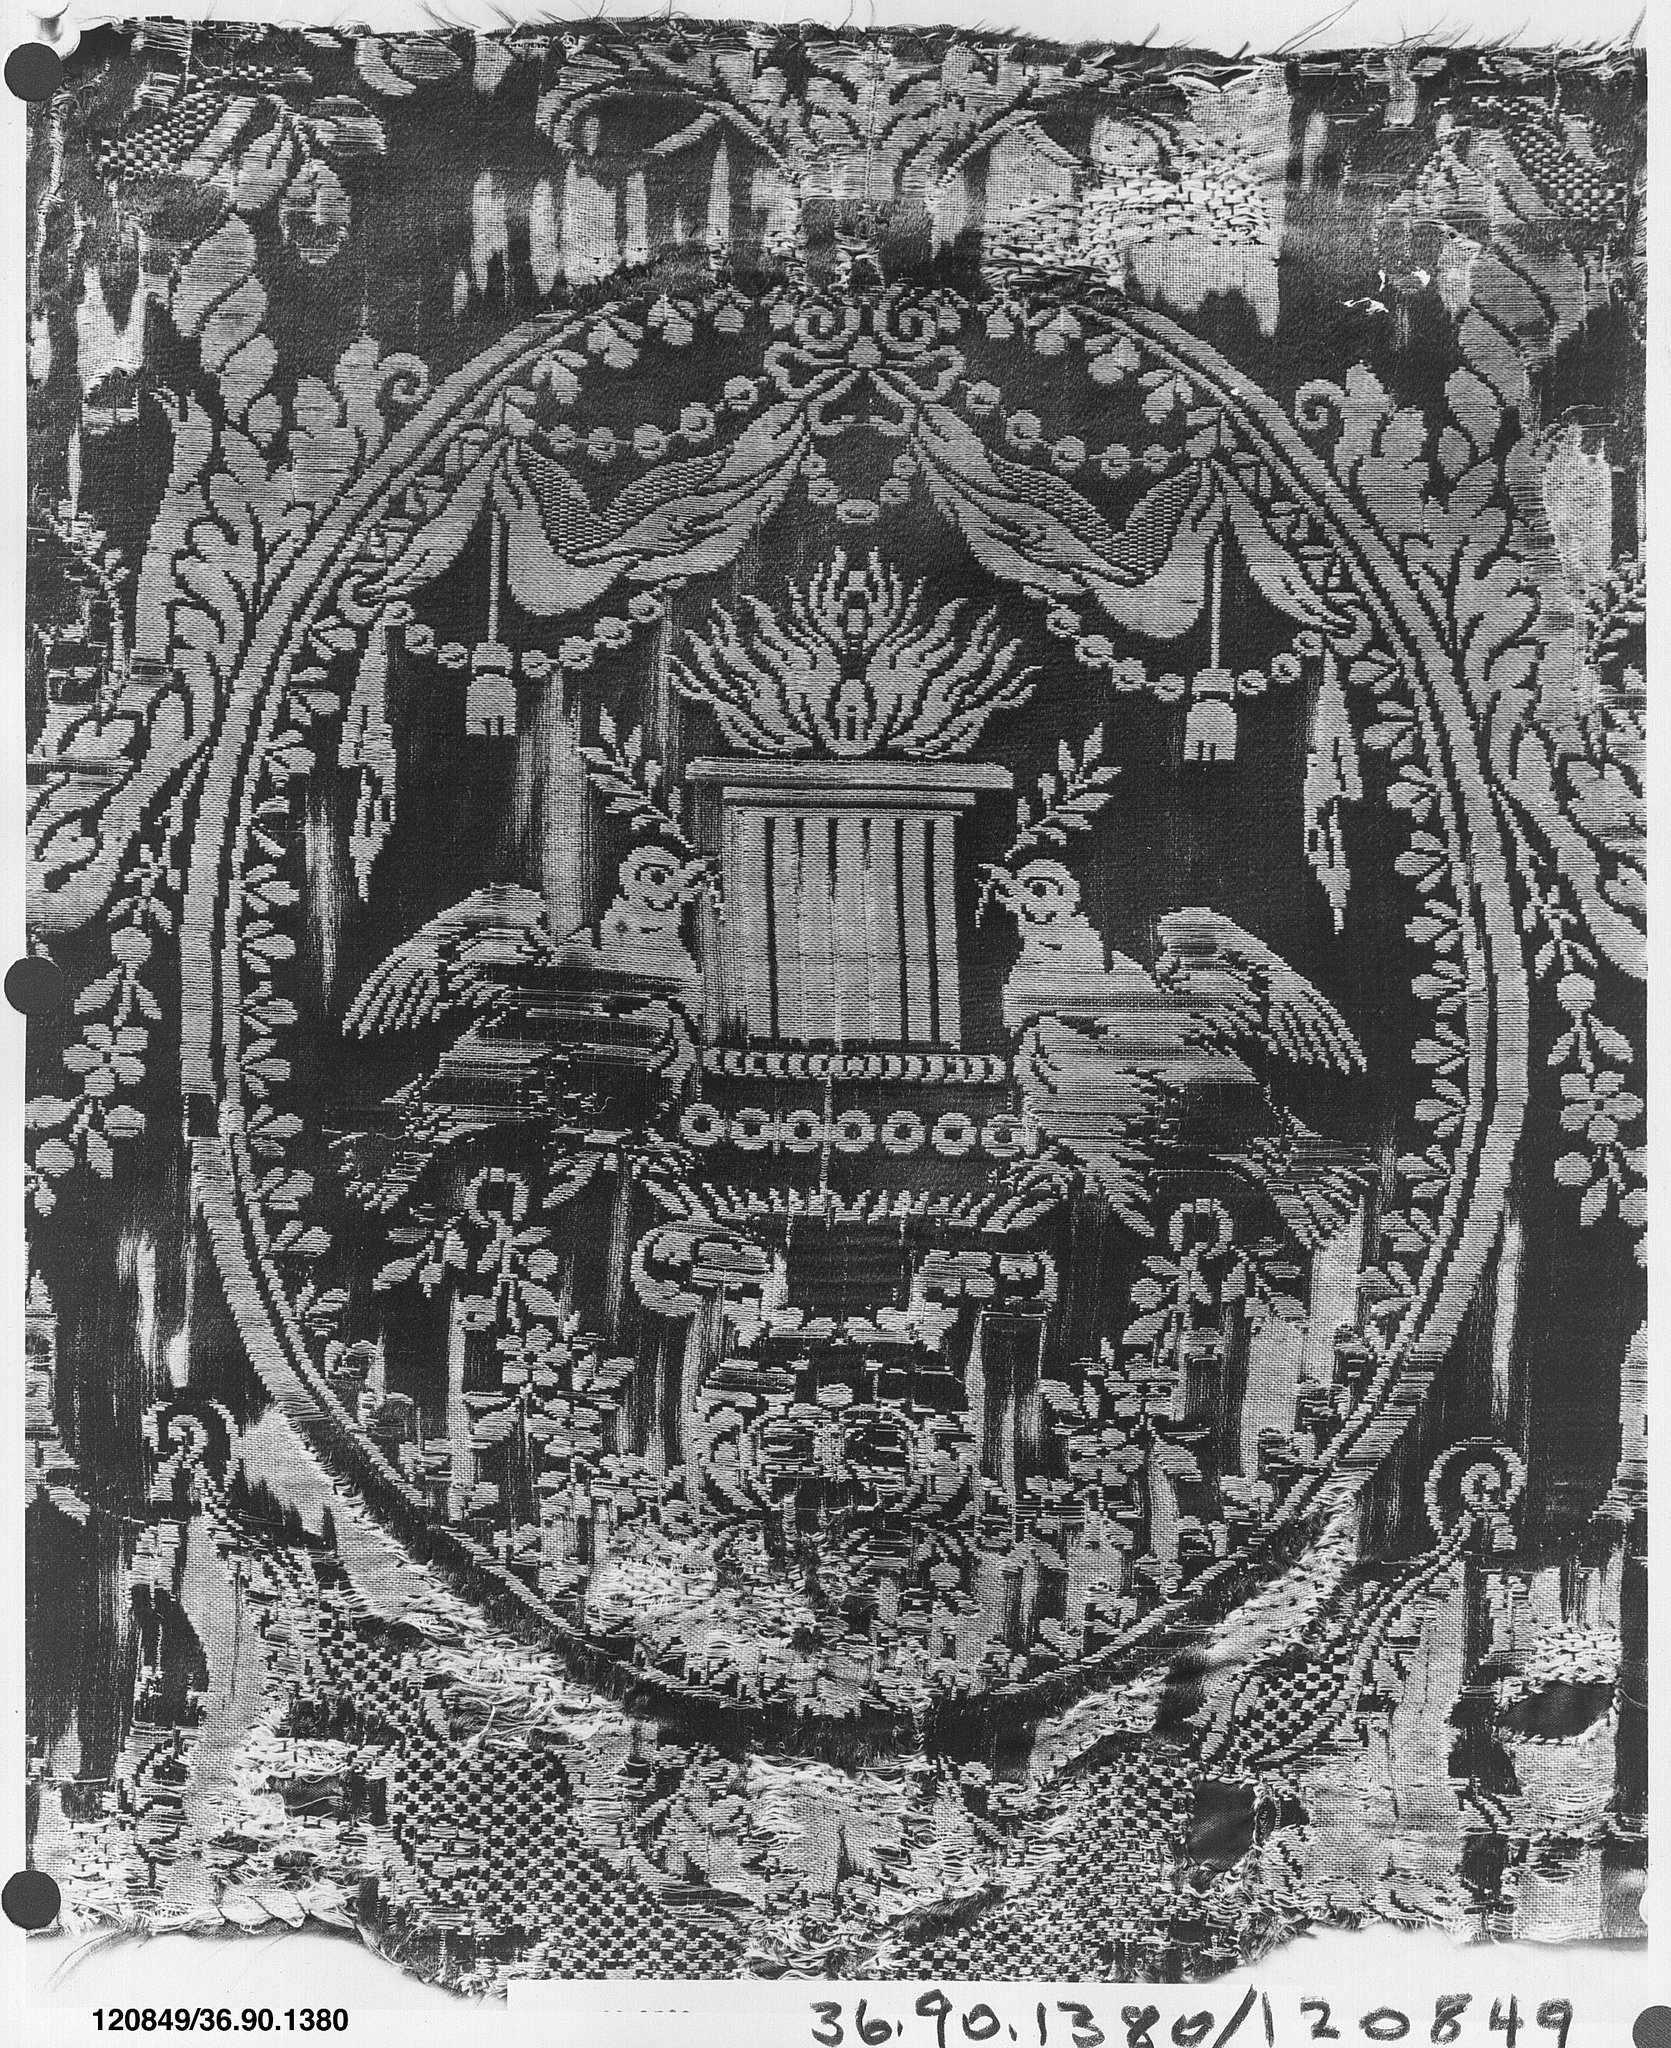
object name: piece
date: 1701-1800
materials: silk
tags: birds,flowers,leaves